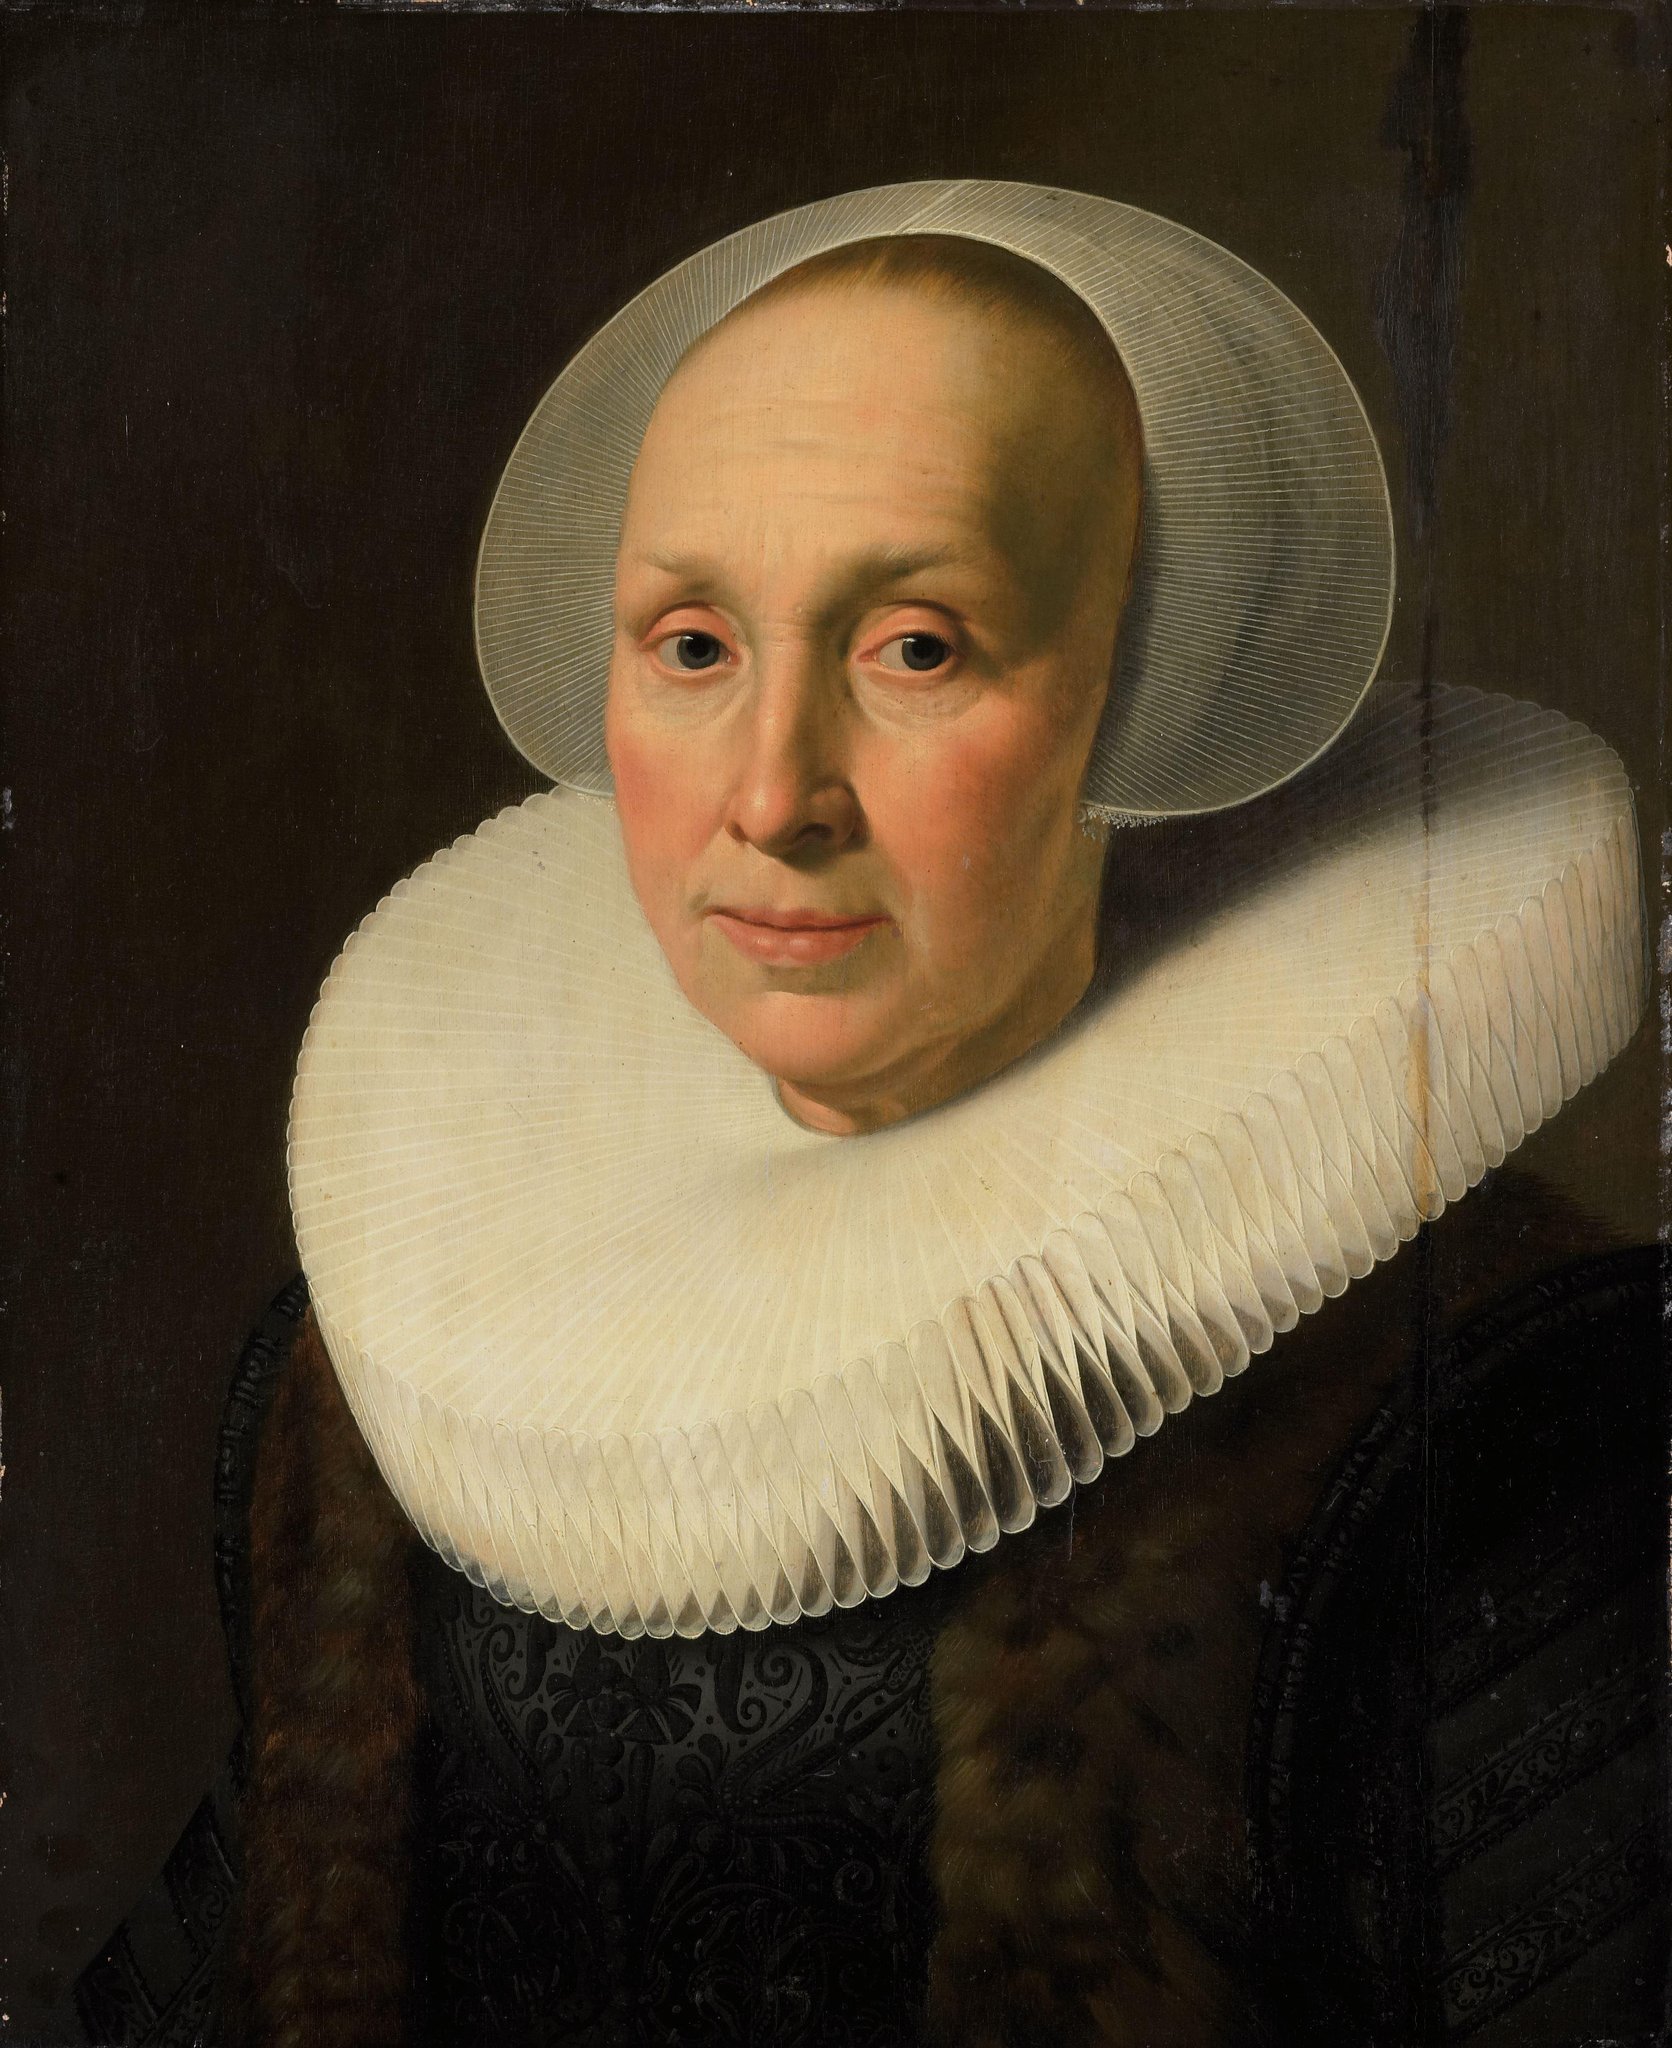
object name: painting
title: Portrait of Margriet Benningh (1565-1641)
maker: nicolaes eliasz pickenoy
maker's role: painter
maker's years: 1588-1656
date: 1629-1640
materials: oil, panel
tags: amsterdam, historical persons - bb - woman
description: Portret van Margriet Benningh (1565-1641), de tweede echtgenote van Pieter Dircksz Hasselaer. Buste naar links. Vroeger beschouwd als een pendant van SK-A-1244, het portret van een man door Aert Pietersz.